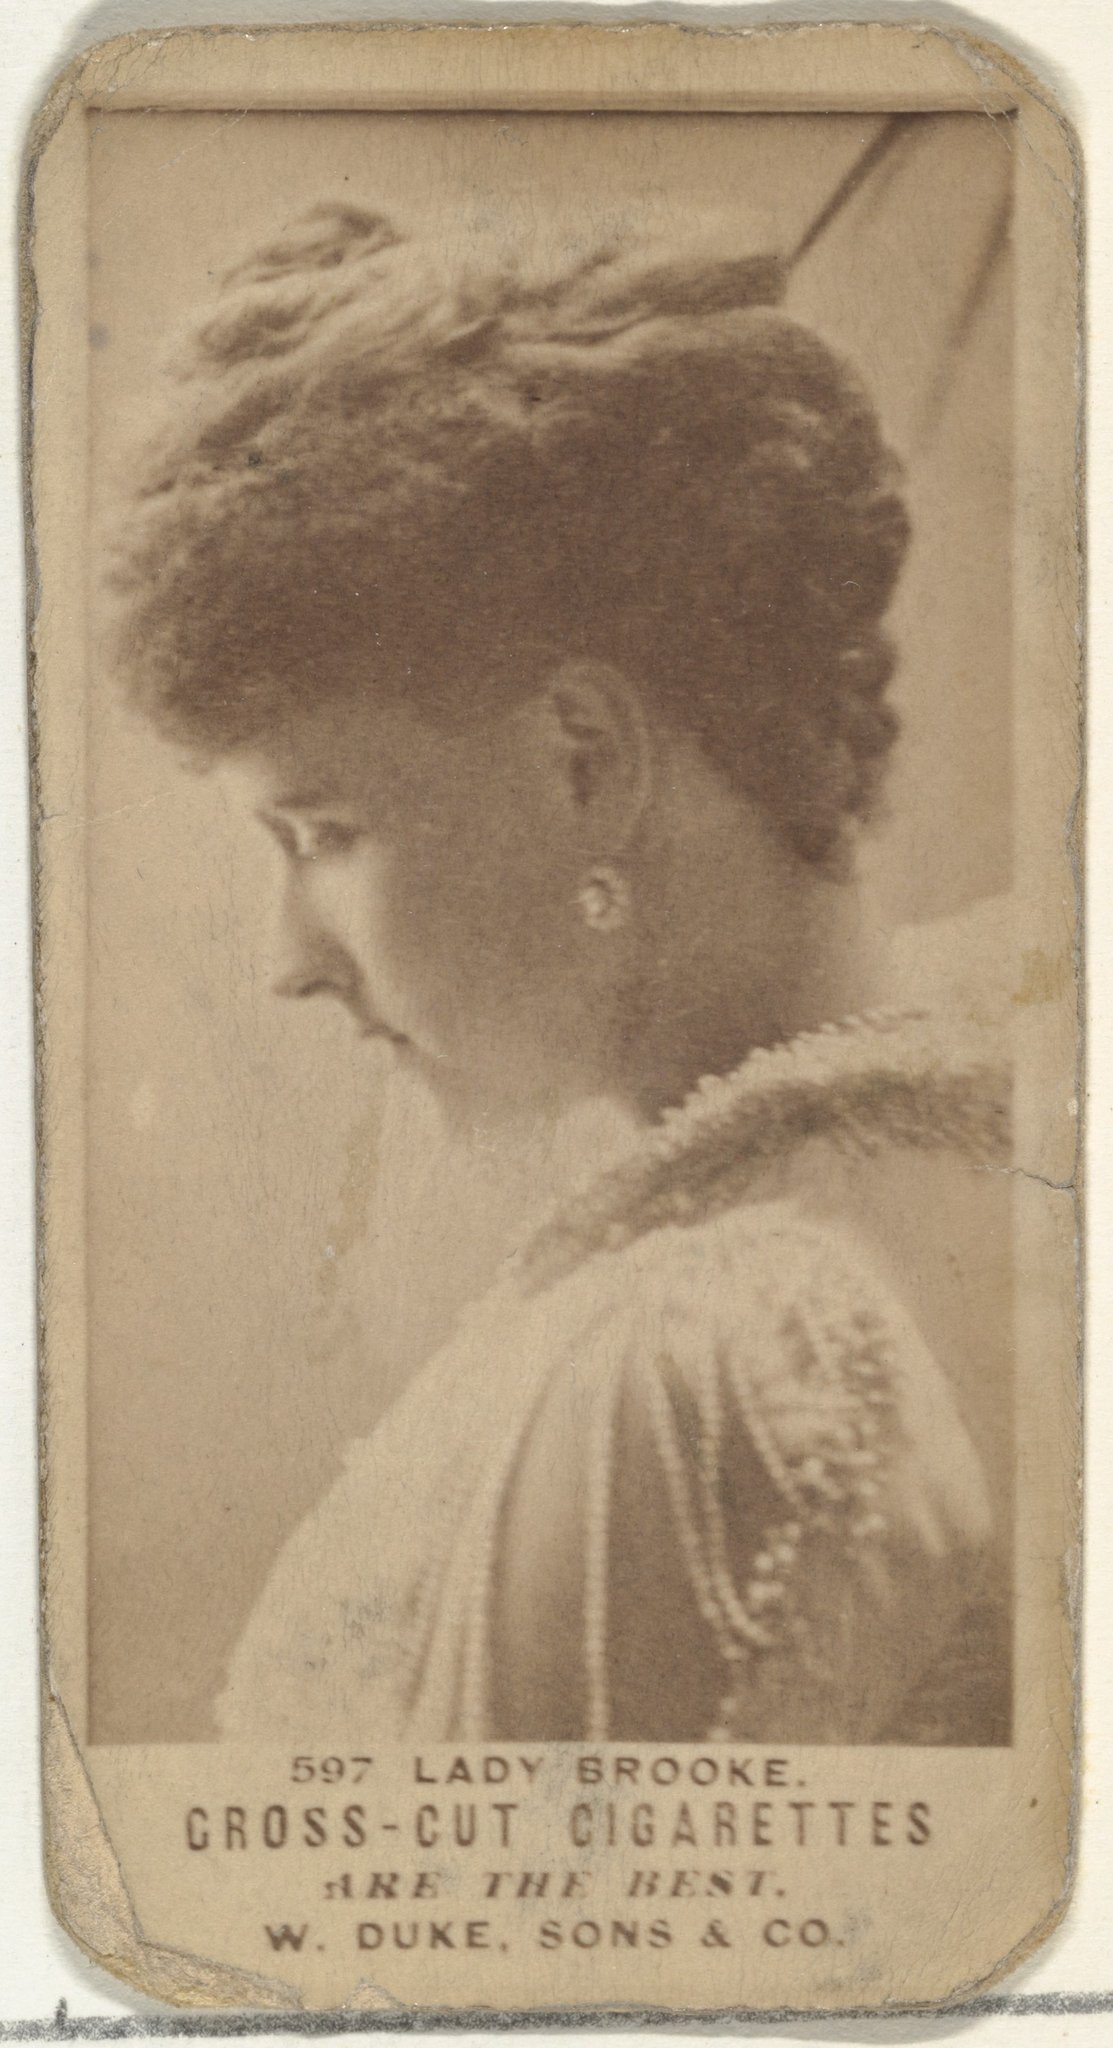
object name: photograph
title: Card Number 597, Lady Brooke, from the Actors and Actresses series (N145-3) issued by Duke Sons & Co. to promote Cross Cut Cigarettes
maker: w. duke, sons & co.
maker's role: publisher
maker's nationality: american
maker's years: 1870-1920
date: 1880-1889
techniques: albumen silver print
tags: women,actresses